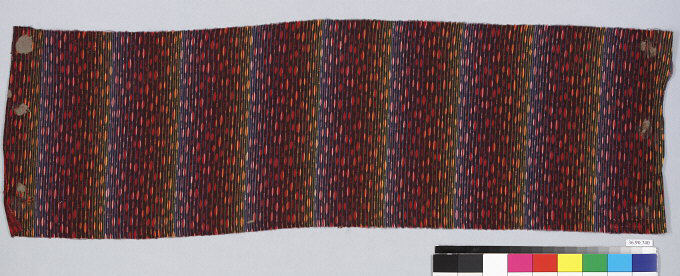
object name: piece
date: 1867-1900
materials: cotton